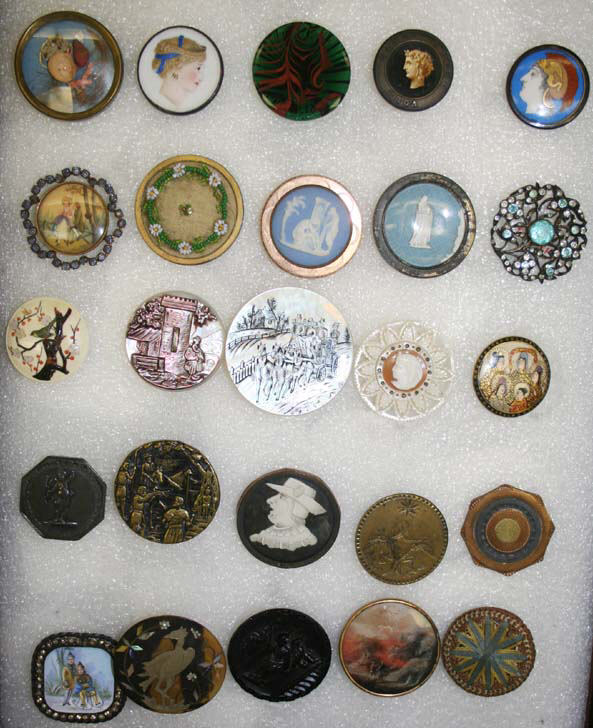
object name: button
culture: american or european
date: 1770-1885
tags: profiles,women